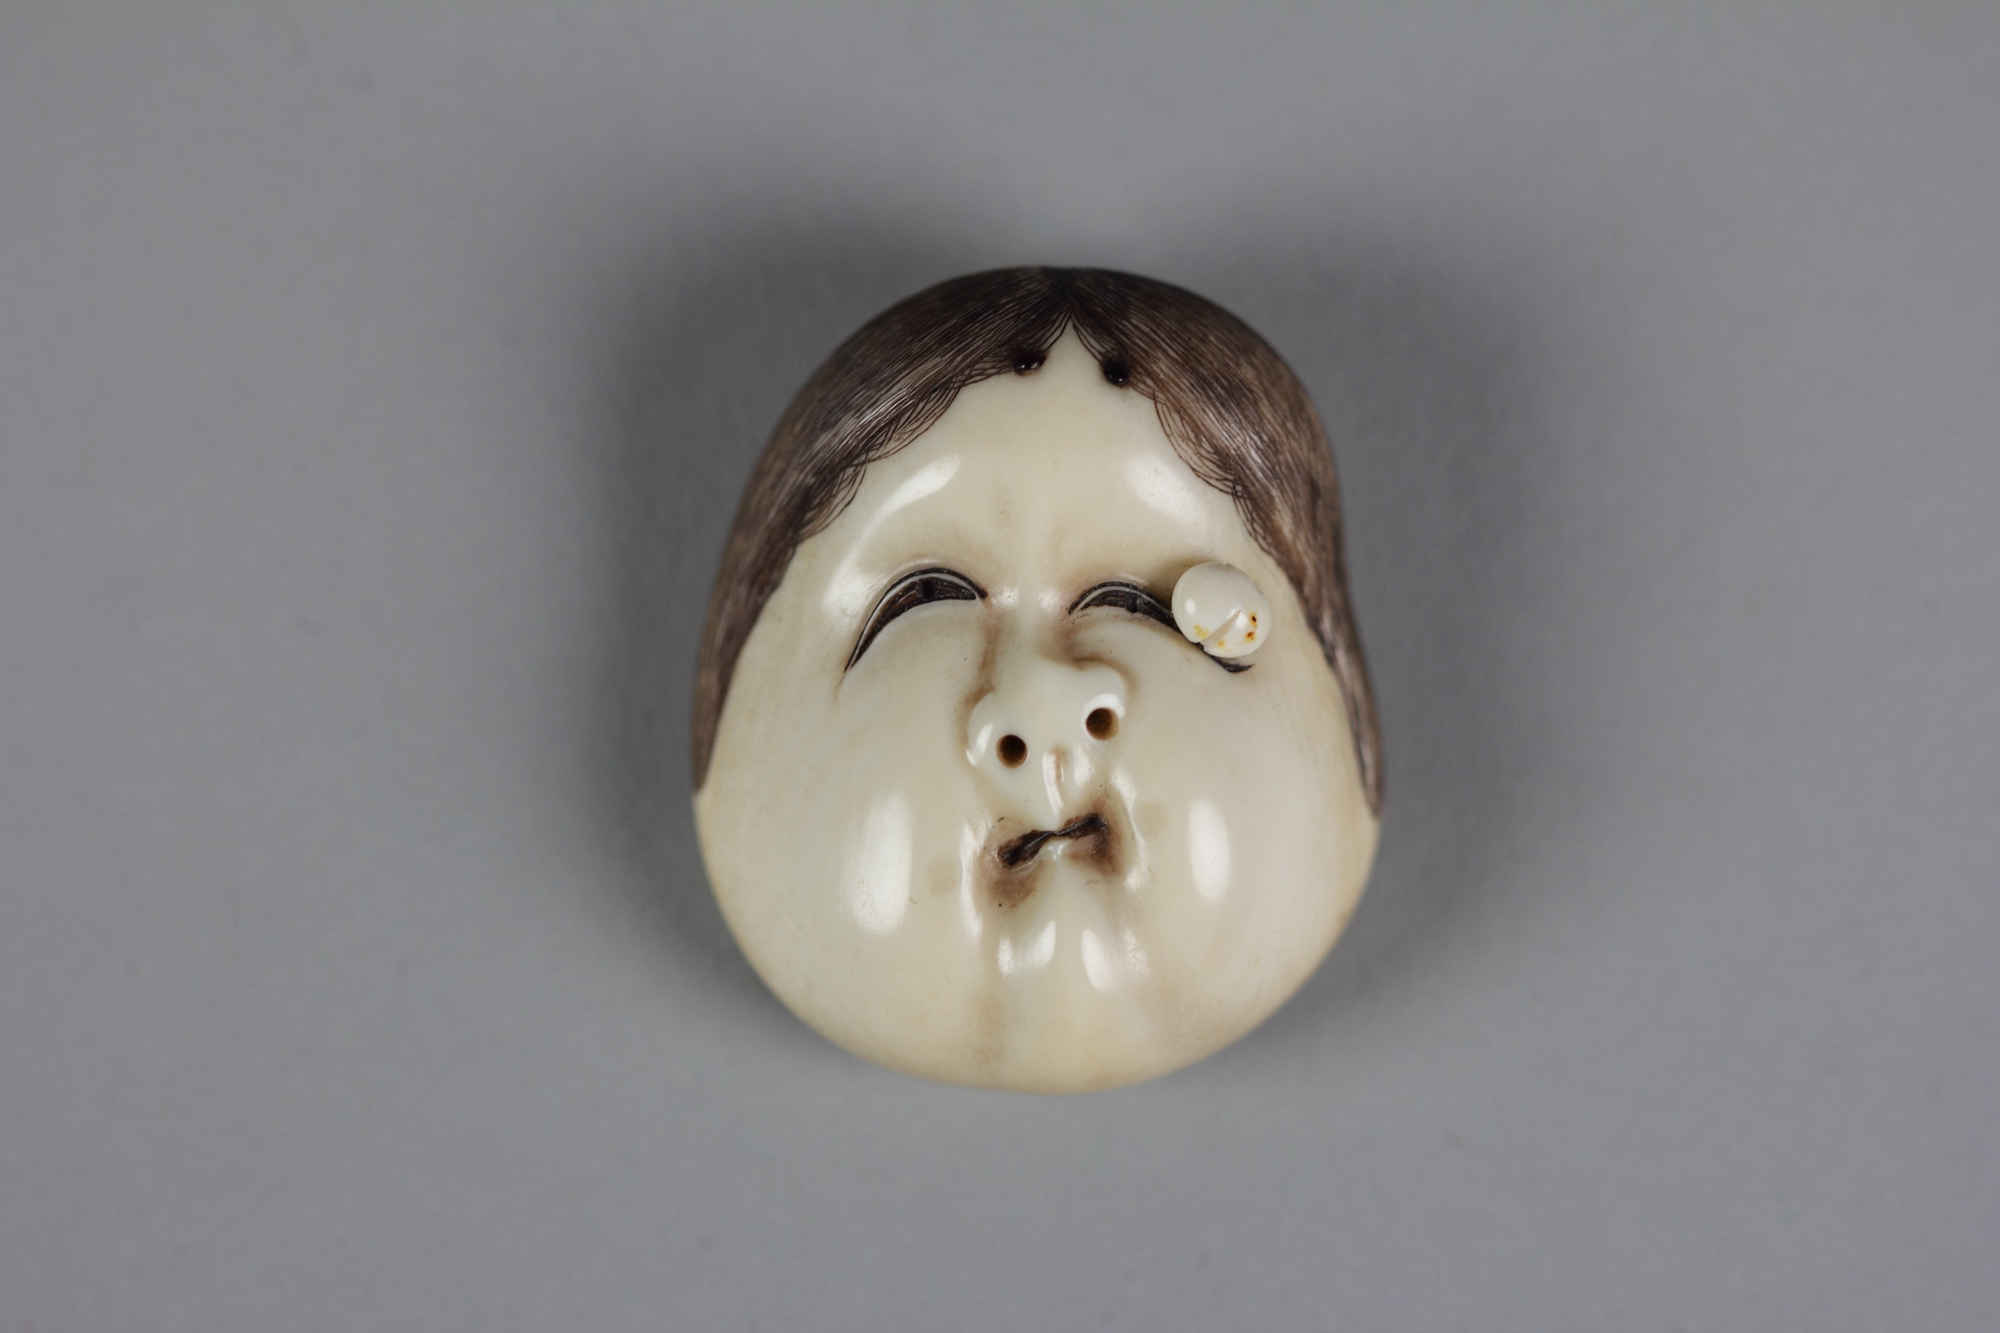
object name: netsuke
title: Netsuke of Okame with Wart Mask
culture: japanese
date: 1801-1833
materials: ivory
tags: masks